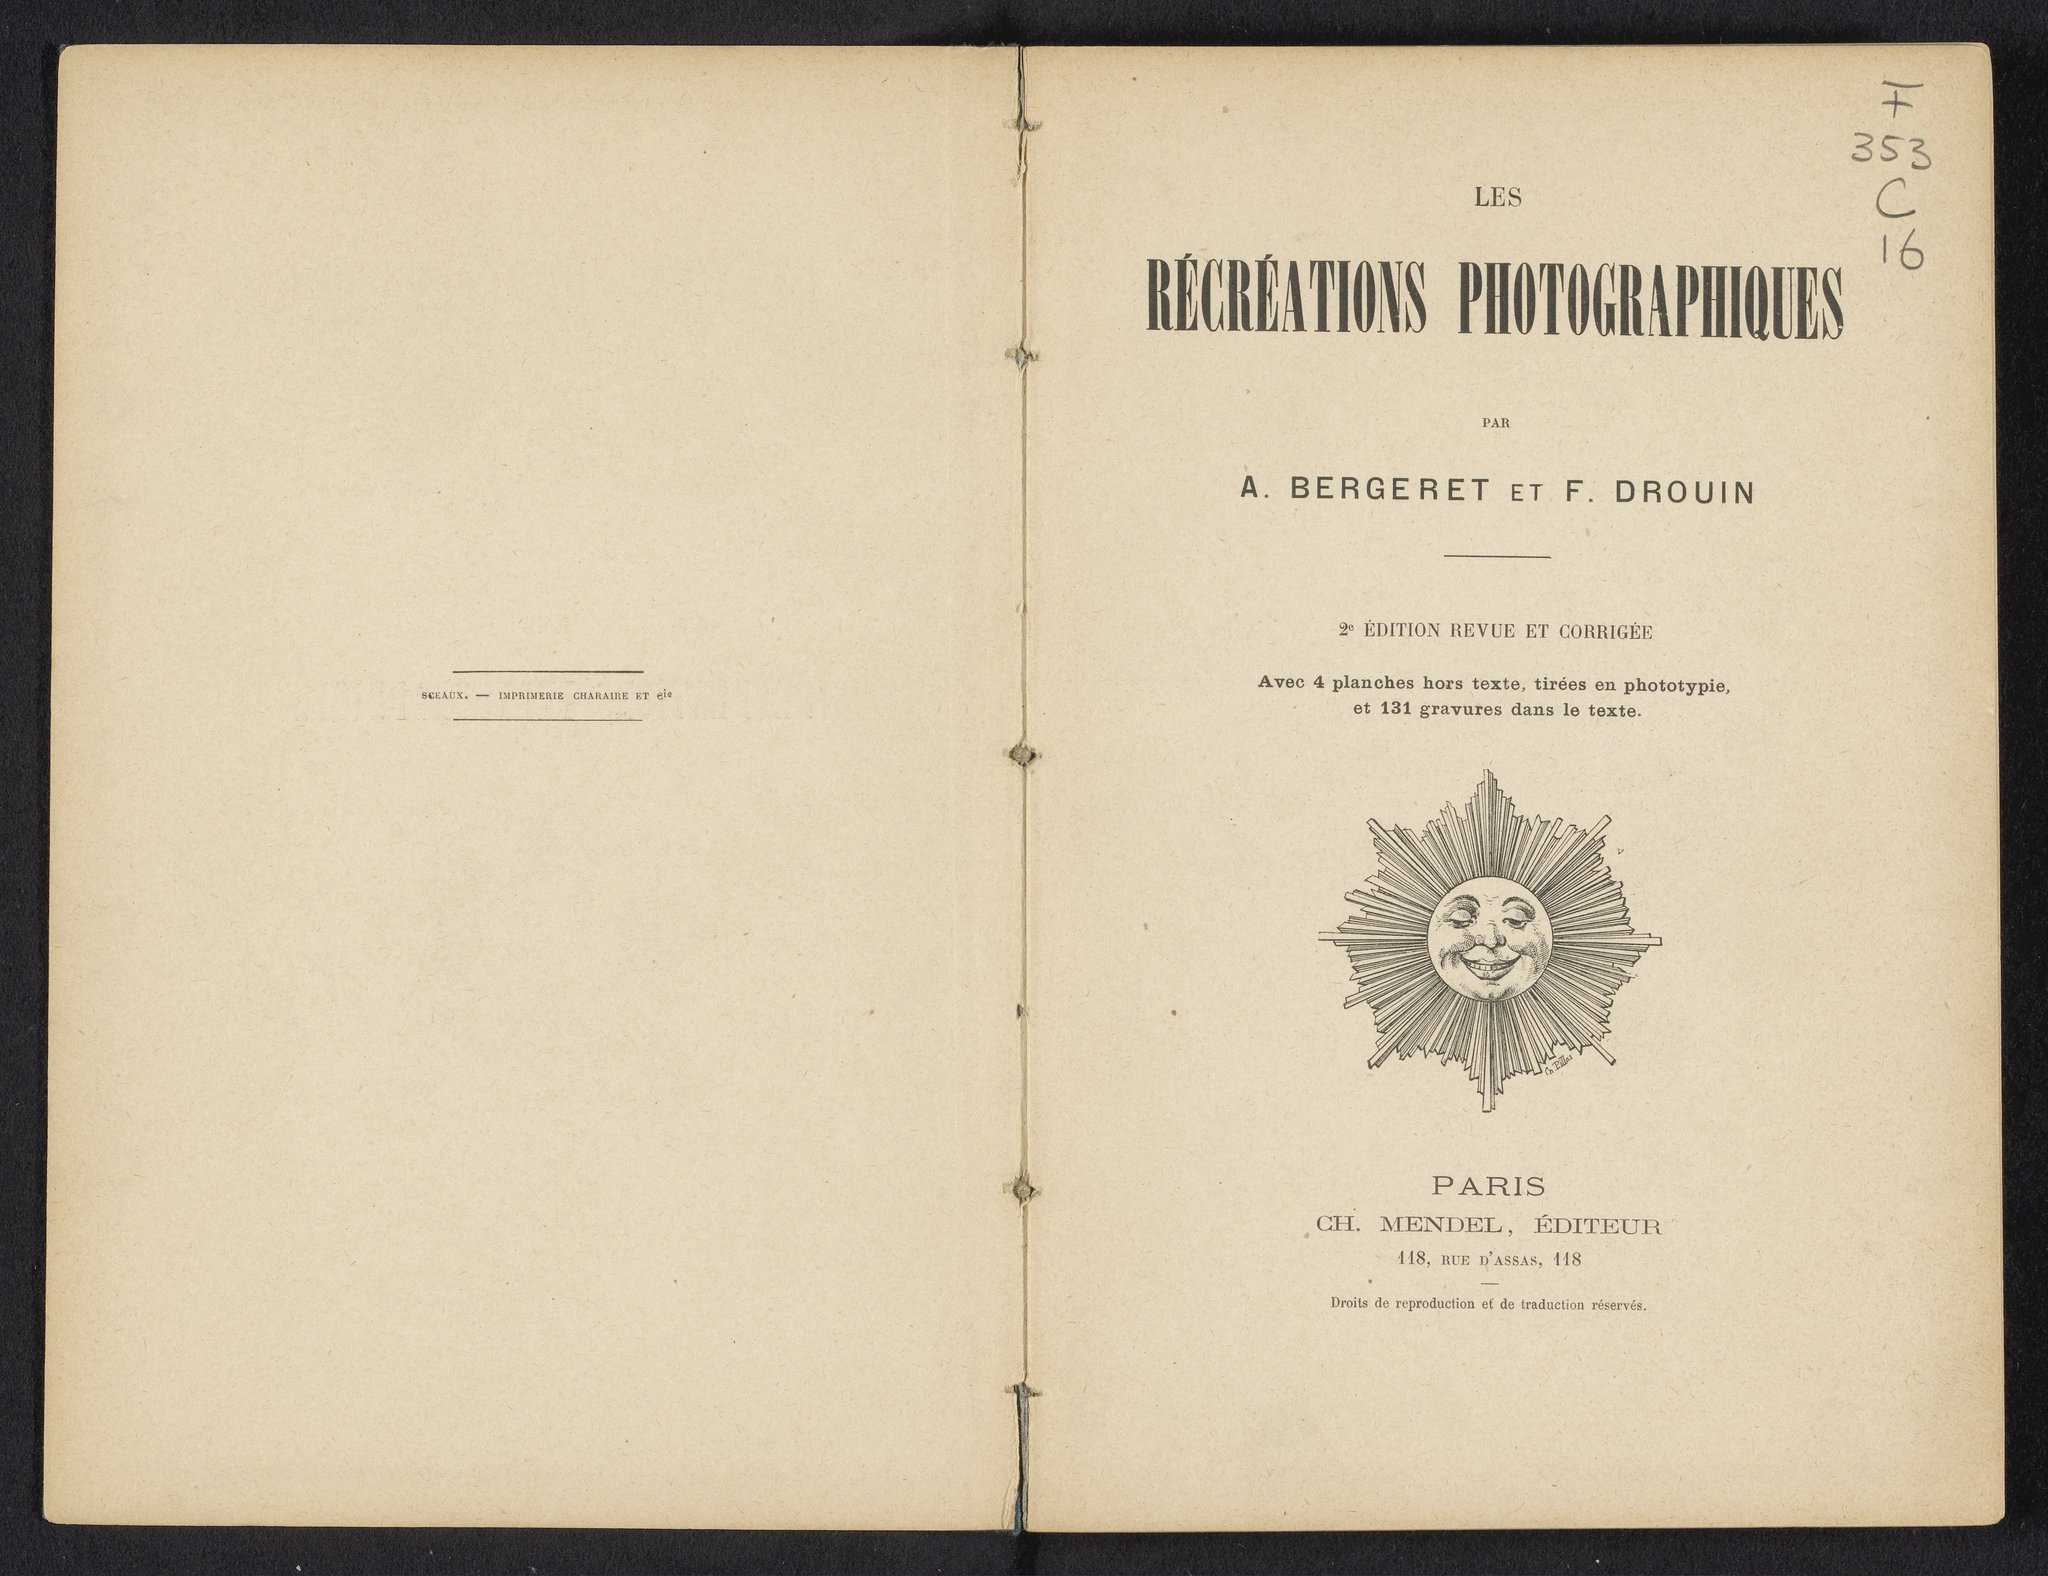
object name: book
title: Les récréations photographiques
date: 1893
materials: linen, paper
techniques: photograph, printing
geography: paris